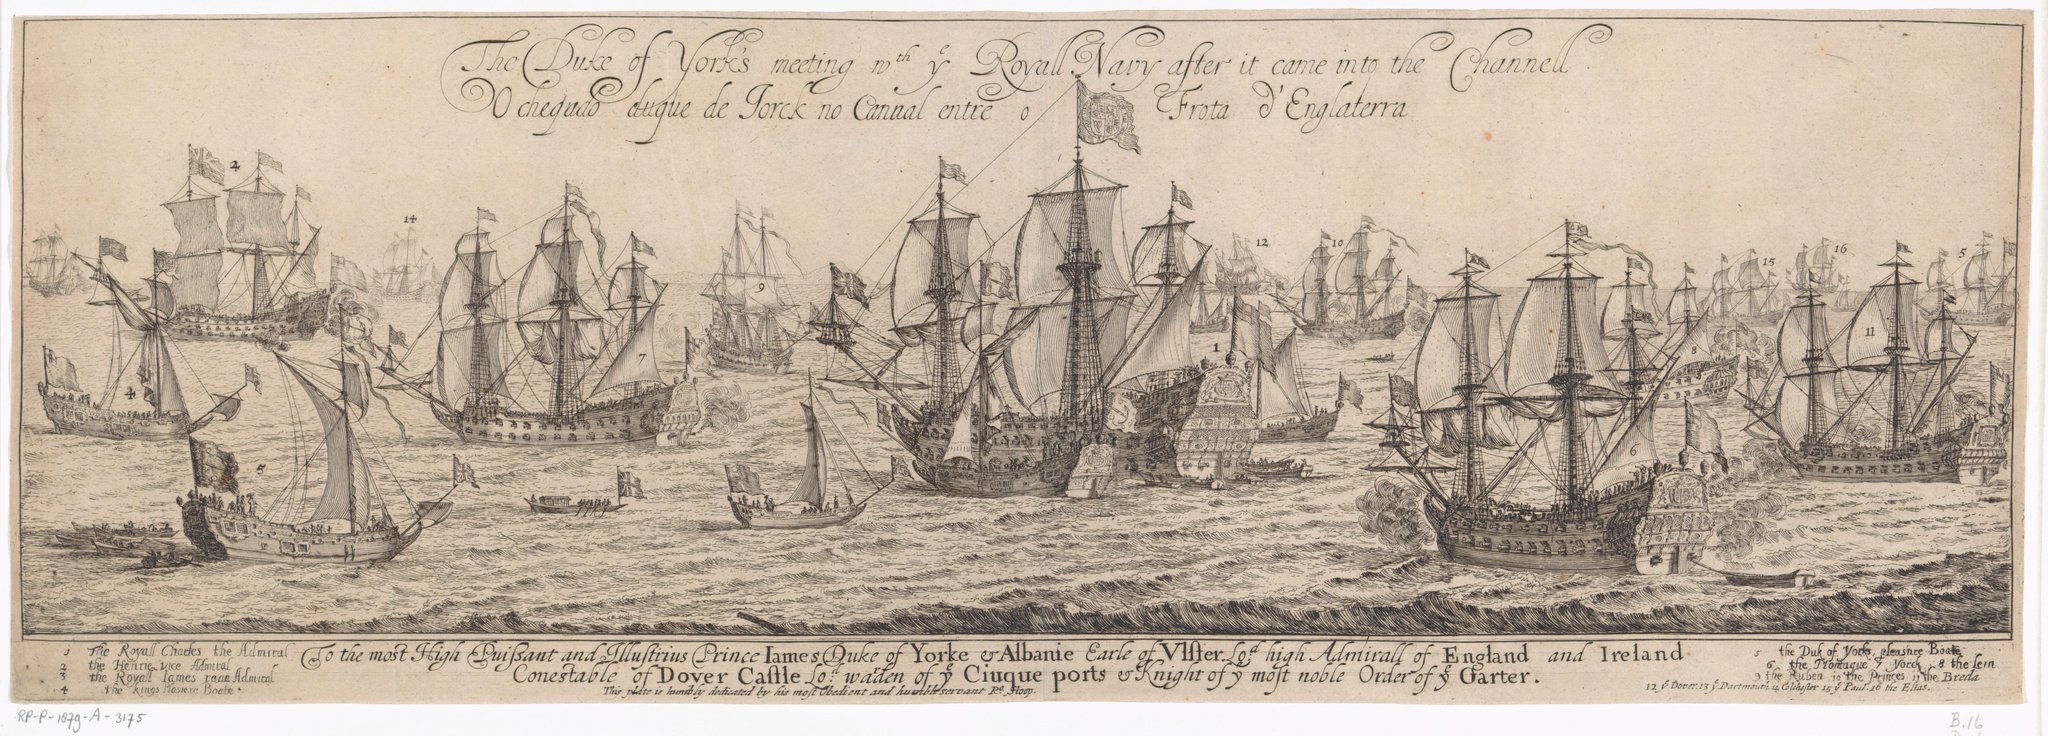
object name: print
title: Hertog van York begroet de Koninklijke Marine in het Kanaal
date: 1662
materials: paper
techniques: engraving, etching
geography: england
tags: jacobus ii (koning van engeland en schotland), catharina van bragança, sailing-ship, sailing-boat, english channel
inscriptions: collector's mark: Lugt 2228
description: De schepen van de Hertog van York ontmoeten de schepen van de Engelse marine, die Catharina van Braganza naar Londen brengen en begeleiden, in het Kanaal. Onderaan in de marge een legenda met nummers, die verwijzen naar schepen in de voorstelling. Prent maakt deel uit van een serie over de reis van Catharina van Braganza van Portugal naar Londen, waar zij met Karel II van Engeland trouwde, in 1662.